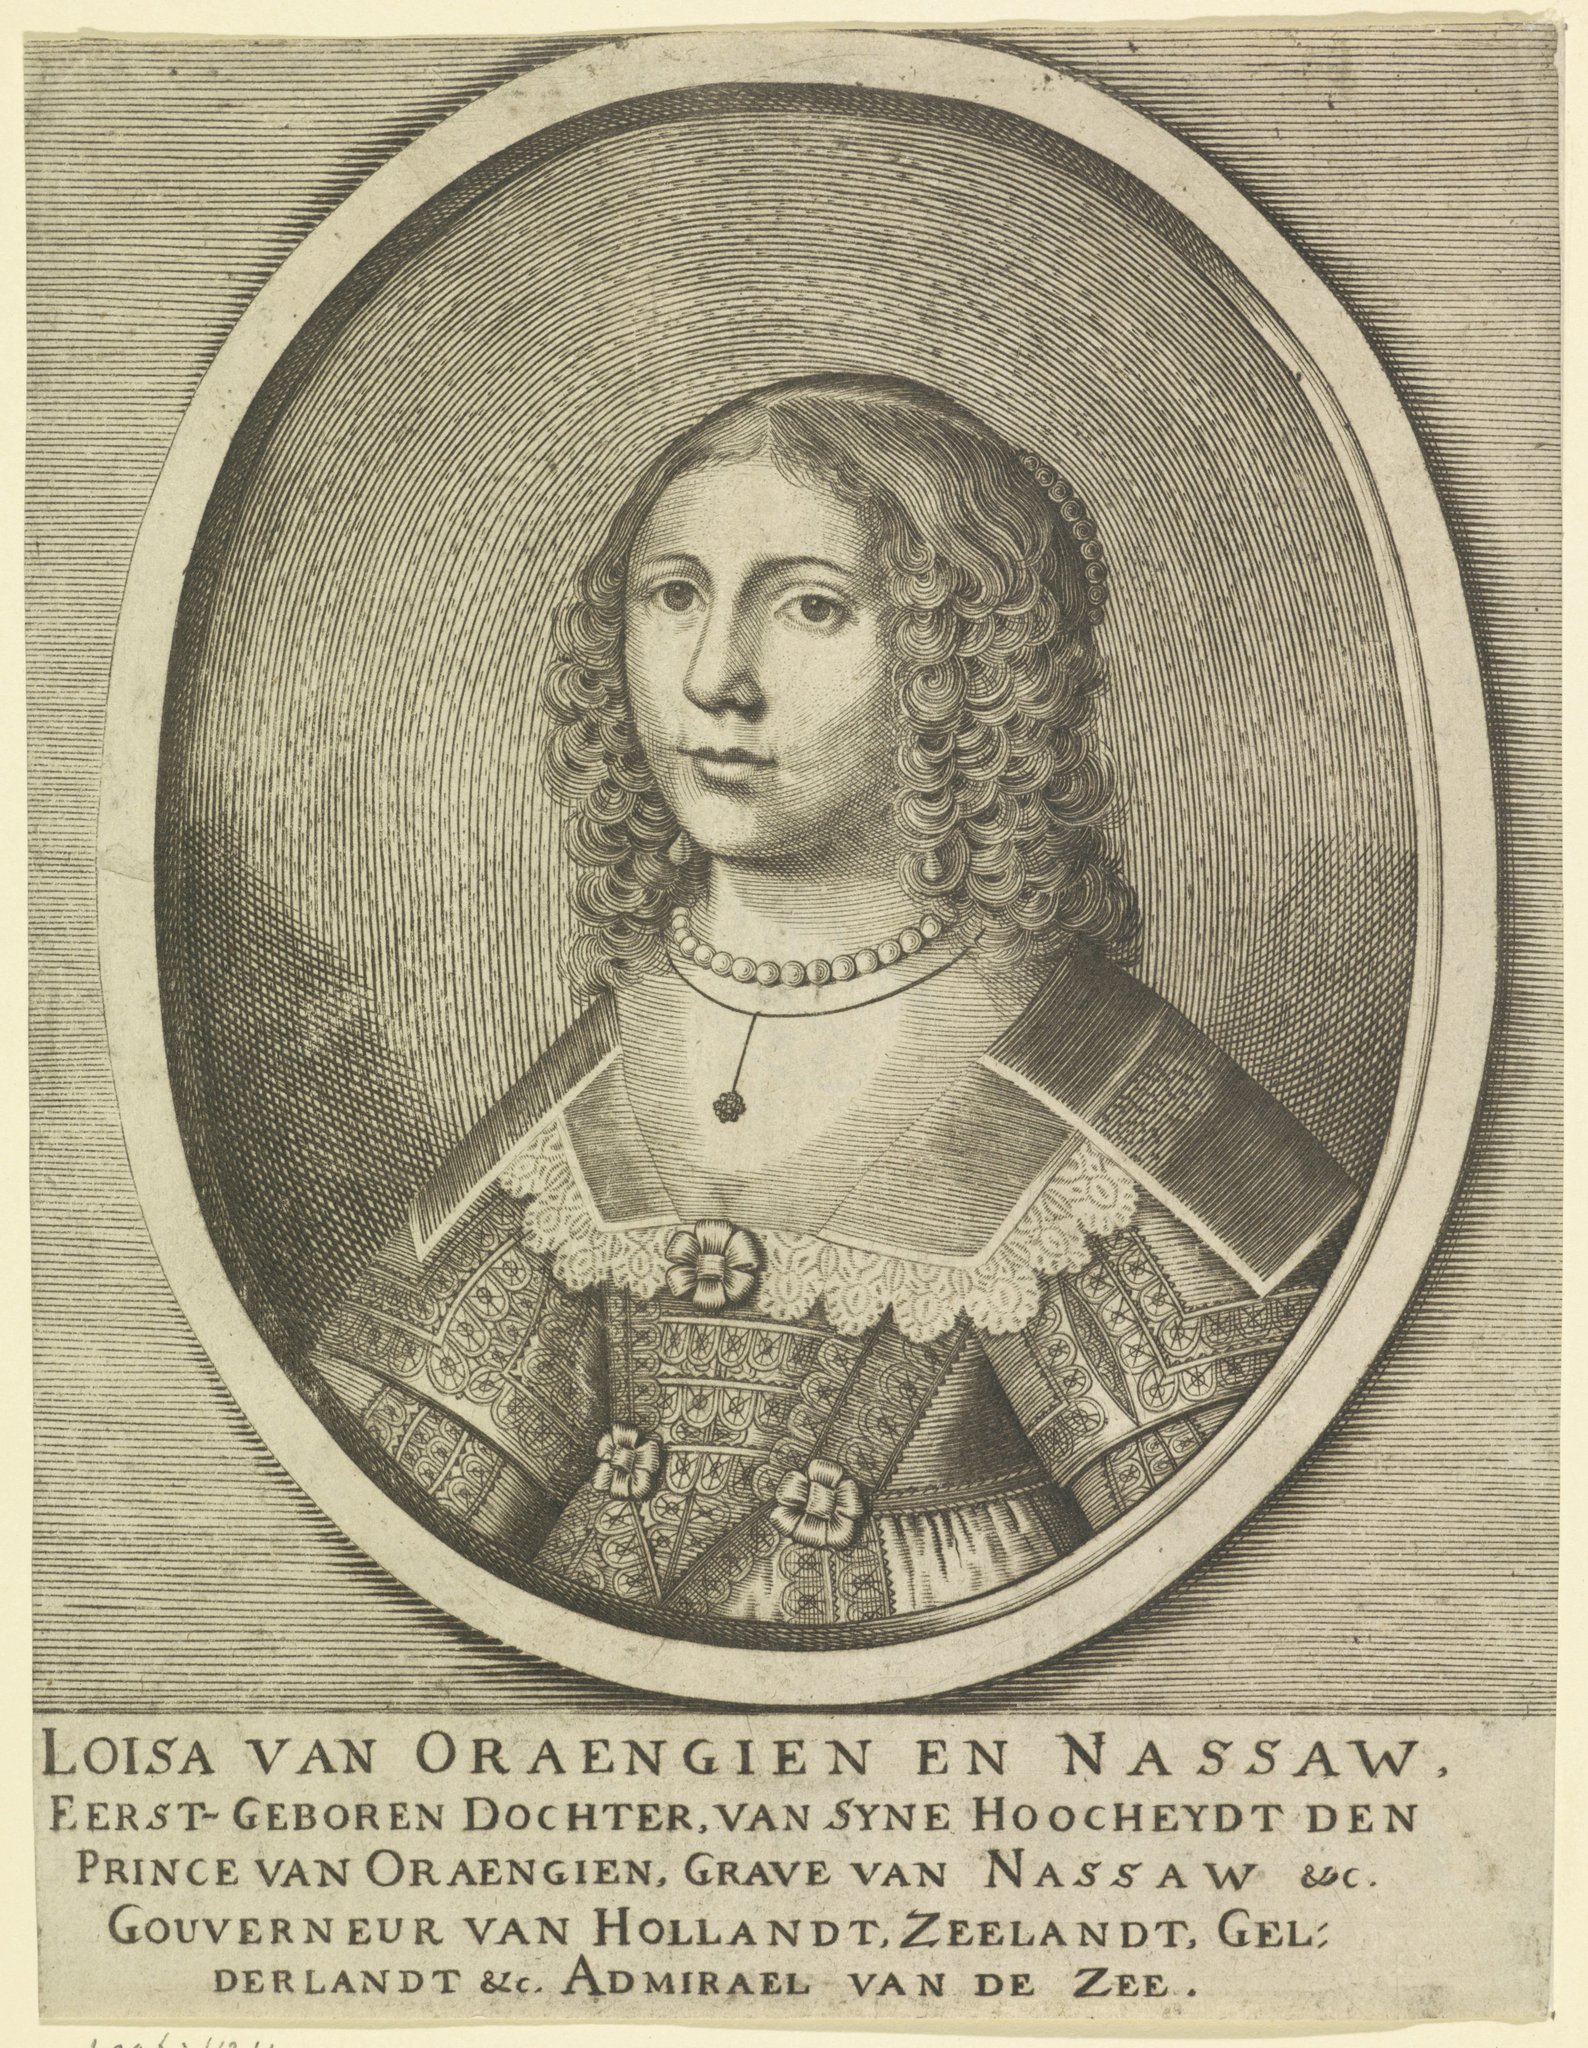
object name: print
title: Portret van Louise Henriëtte, prinses van Oranje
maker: Anonymous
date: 1635-1699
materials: paper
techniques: engraving, etching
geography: low countries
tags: louise henriëtte (prinses van oranje)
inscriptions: collector's mark: Lugt 2228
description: De hier vermelde titel verwijst naar de hoogst verkregen titel van de geportretteerde, niet per se naar de titel die de geportretteerde op deze voorstelling draagt.